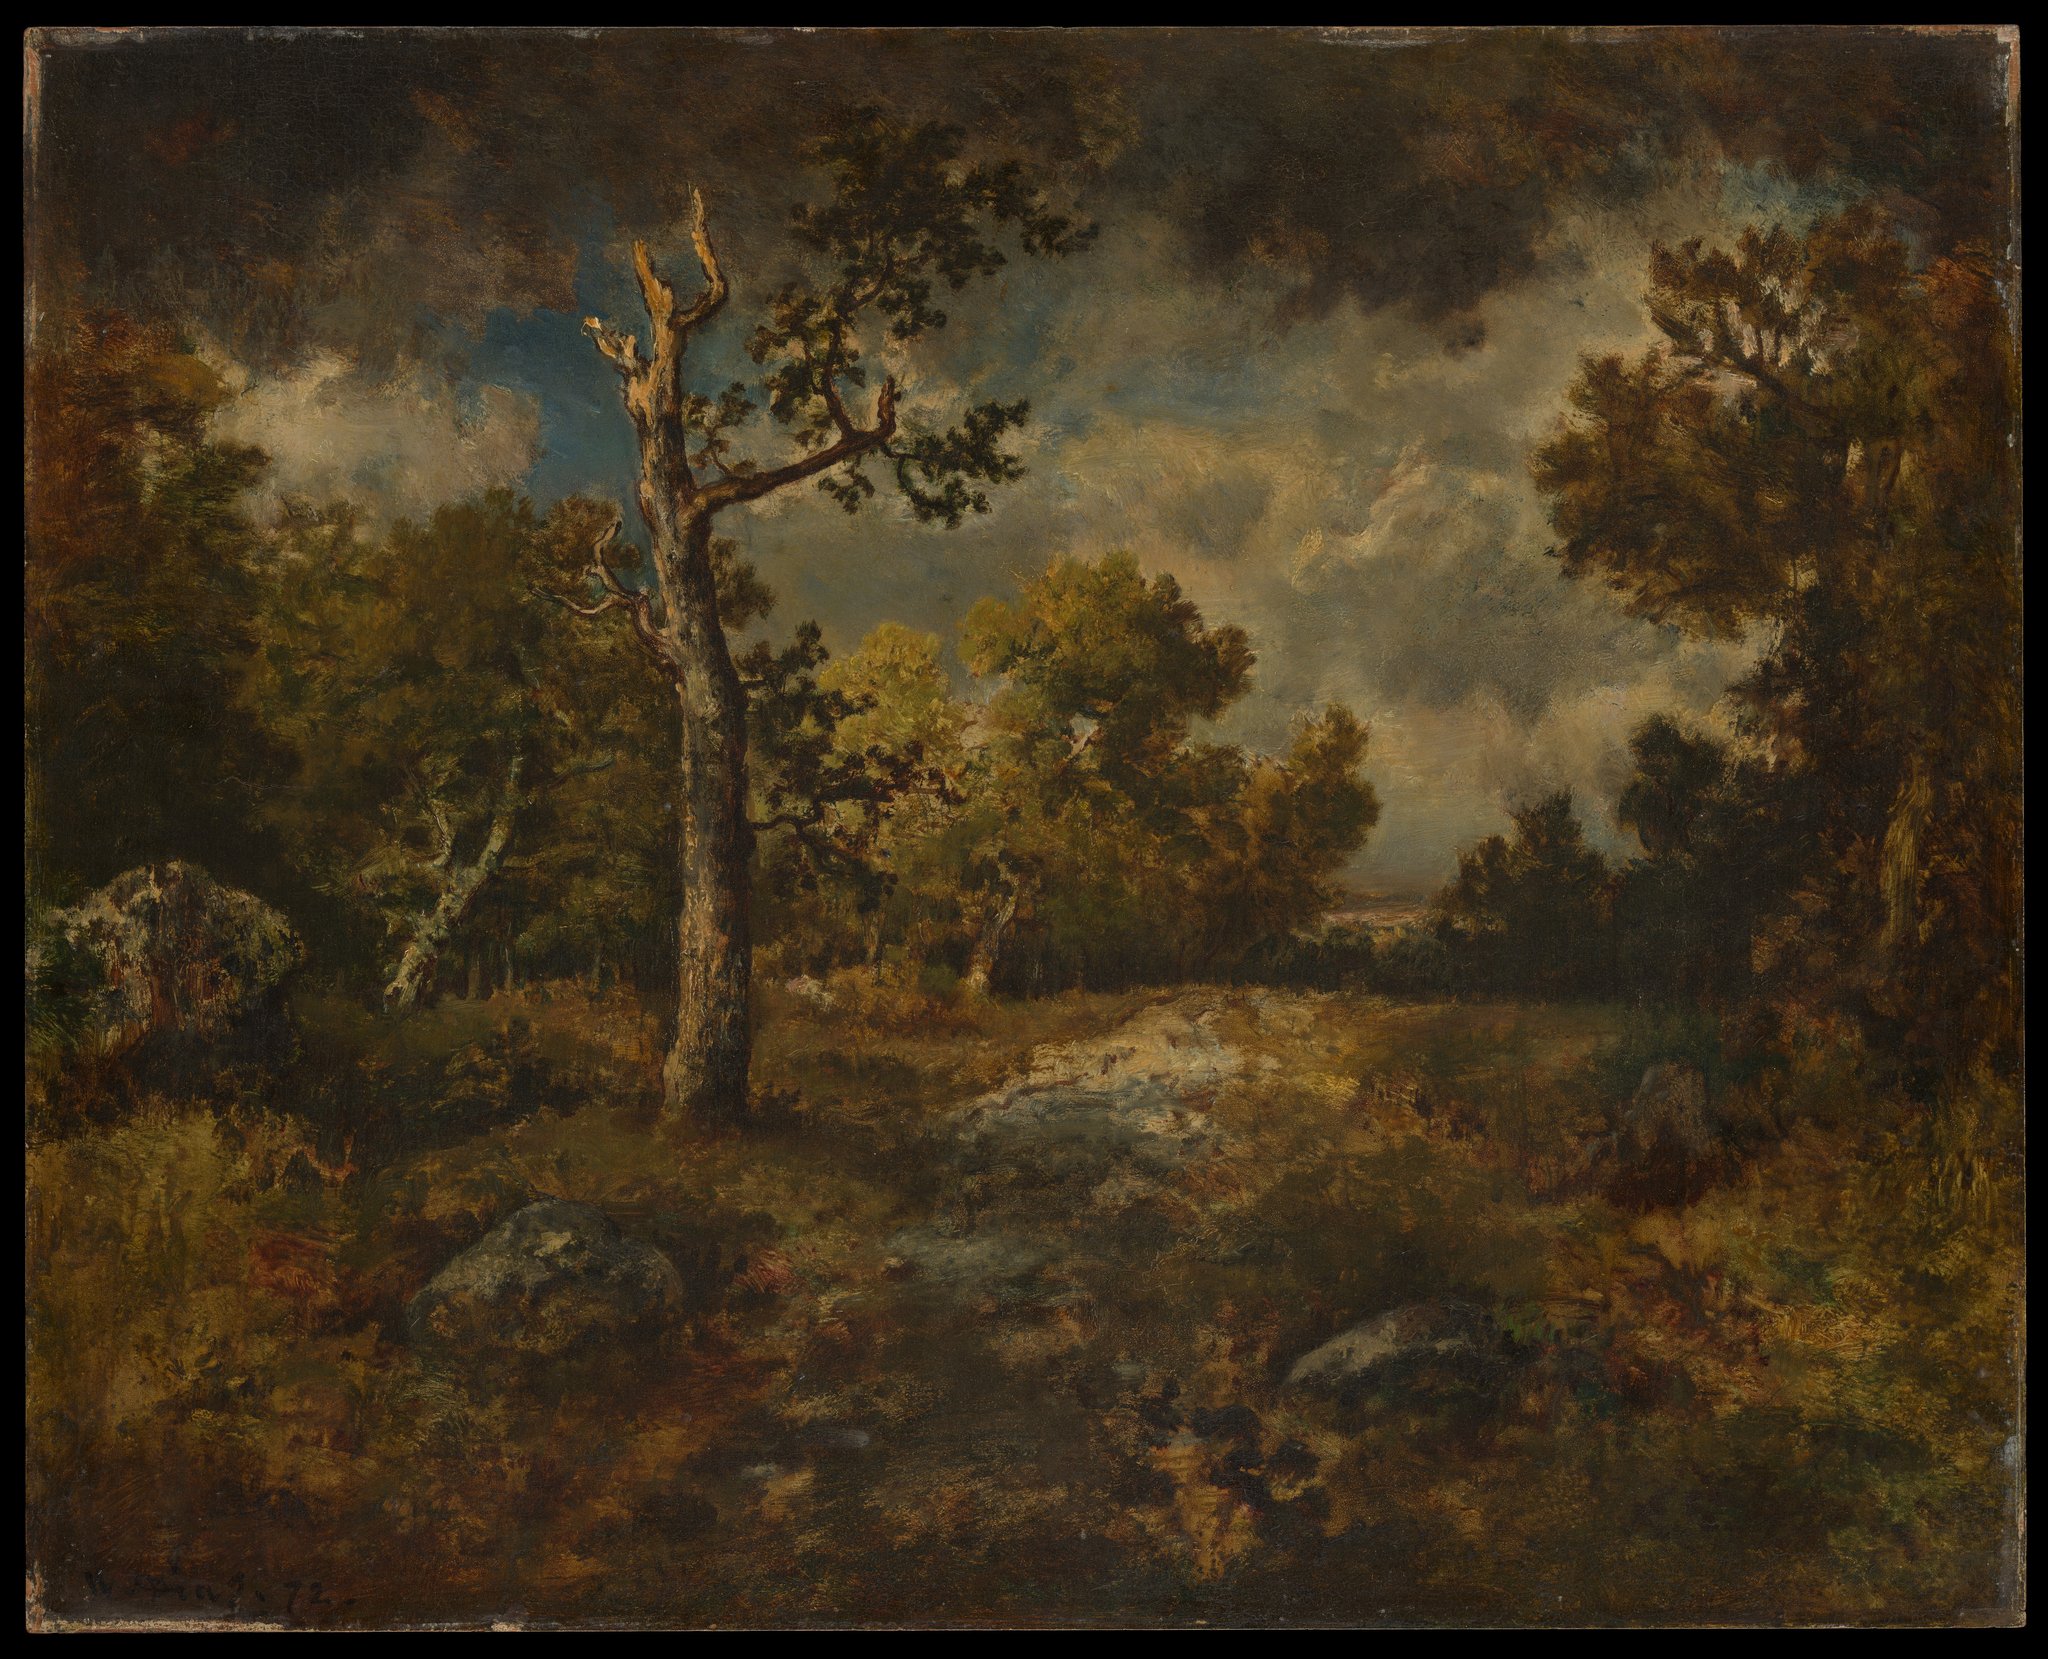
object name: painting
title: The Edge of the Woods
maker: narcisse-virgile diaz de la peña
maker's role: artist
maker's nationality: french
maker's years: 1808-1876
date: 1872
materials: oil, wood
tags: forests,landscapes